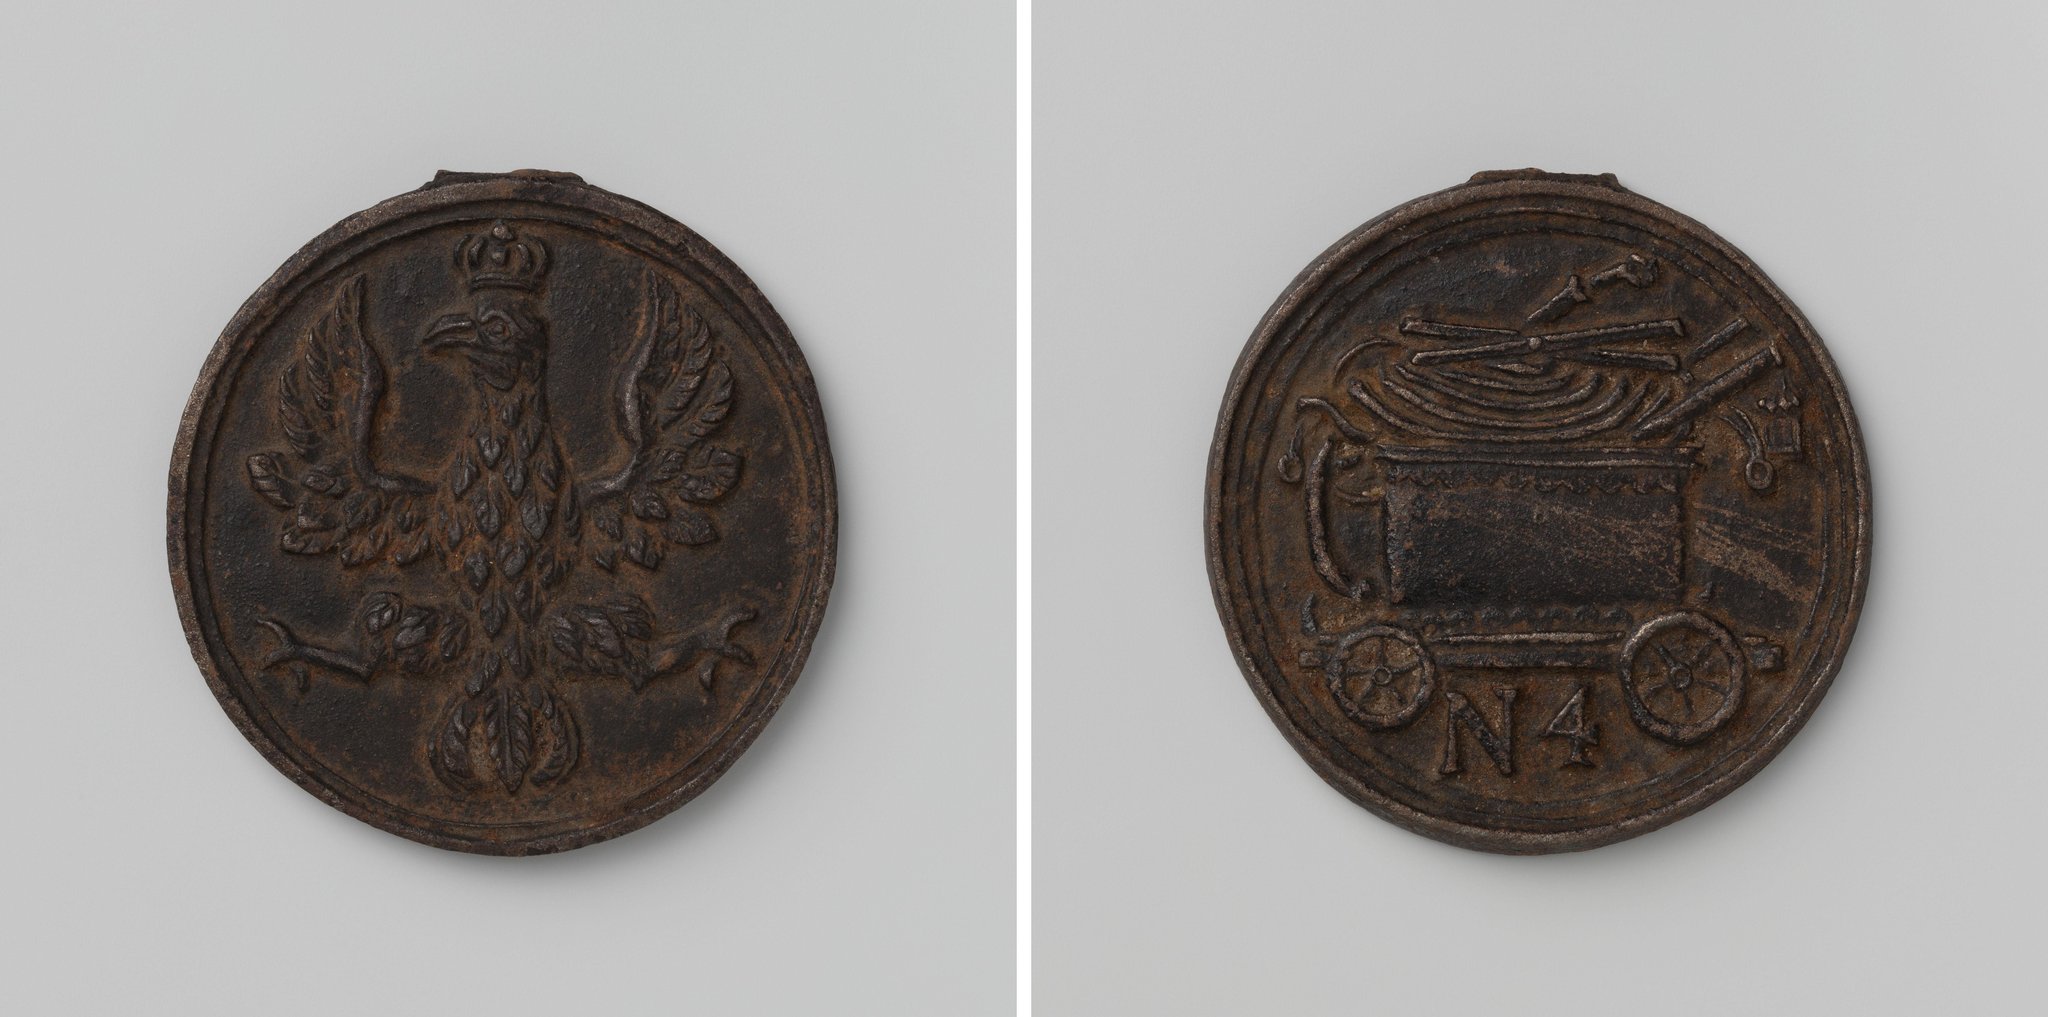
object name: medal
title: Deventer, brandspuitpenning met no. 4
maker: Anonymous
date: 1680-1800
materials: iron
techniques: casting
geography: deventer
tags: deventer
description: IJzeren penning met afgebroken draagoog. Voorzijde: gekroonde adelaar met gespreide vleugels. Keerzijde: rijdende brandspuit boven cijfer No. 4.